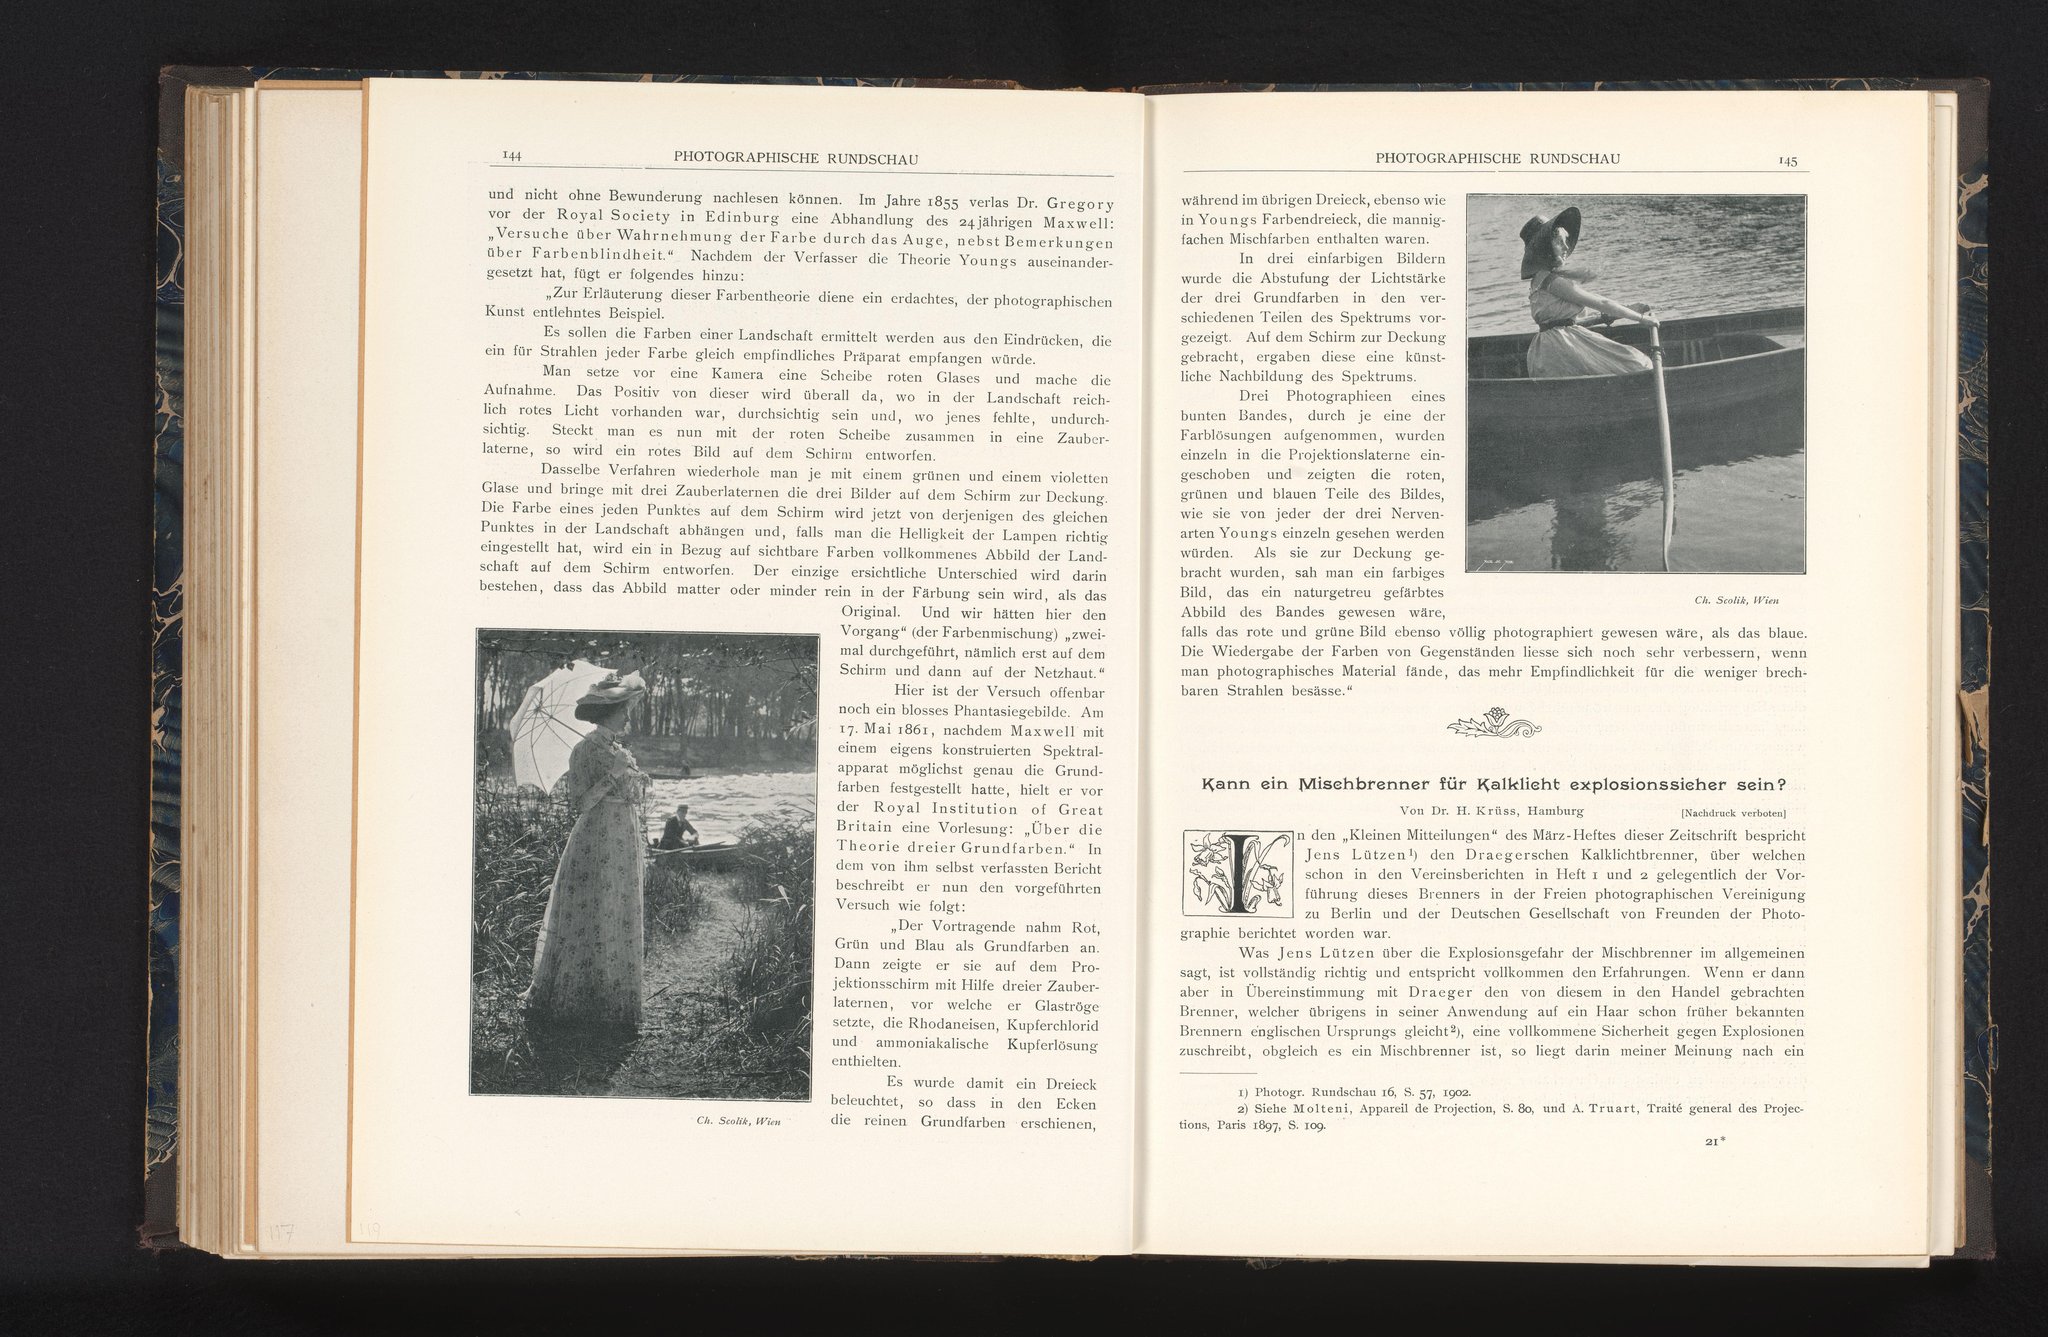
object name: photomechanical print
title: Gezicht op een onbekende jonge vrouw in een roeiboot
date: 1897-1902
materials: paper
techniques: autotype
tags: adolescent, young woman, maiden, rowing-boat, canoe, etc.